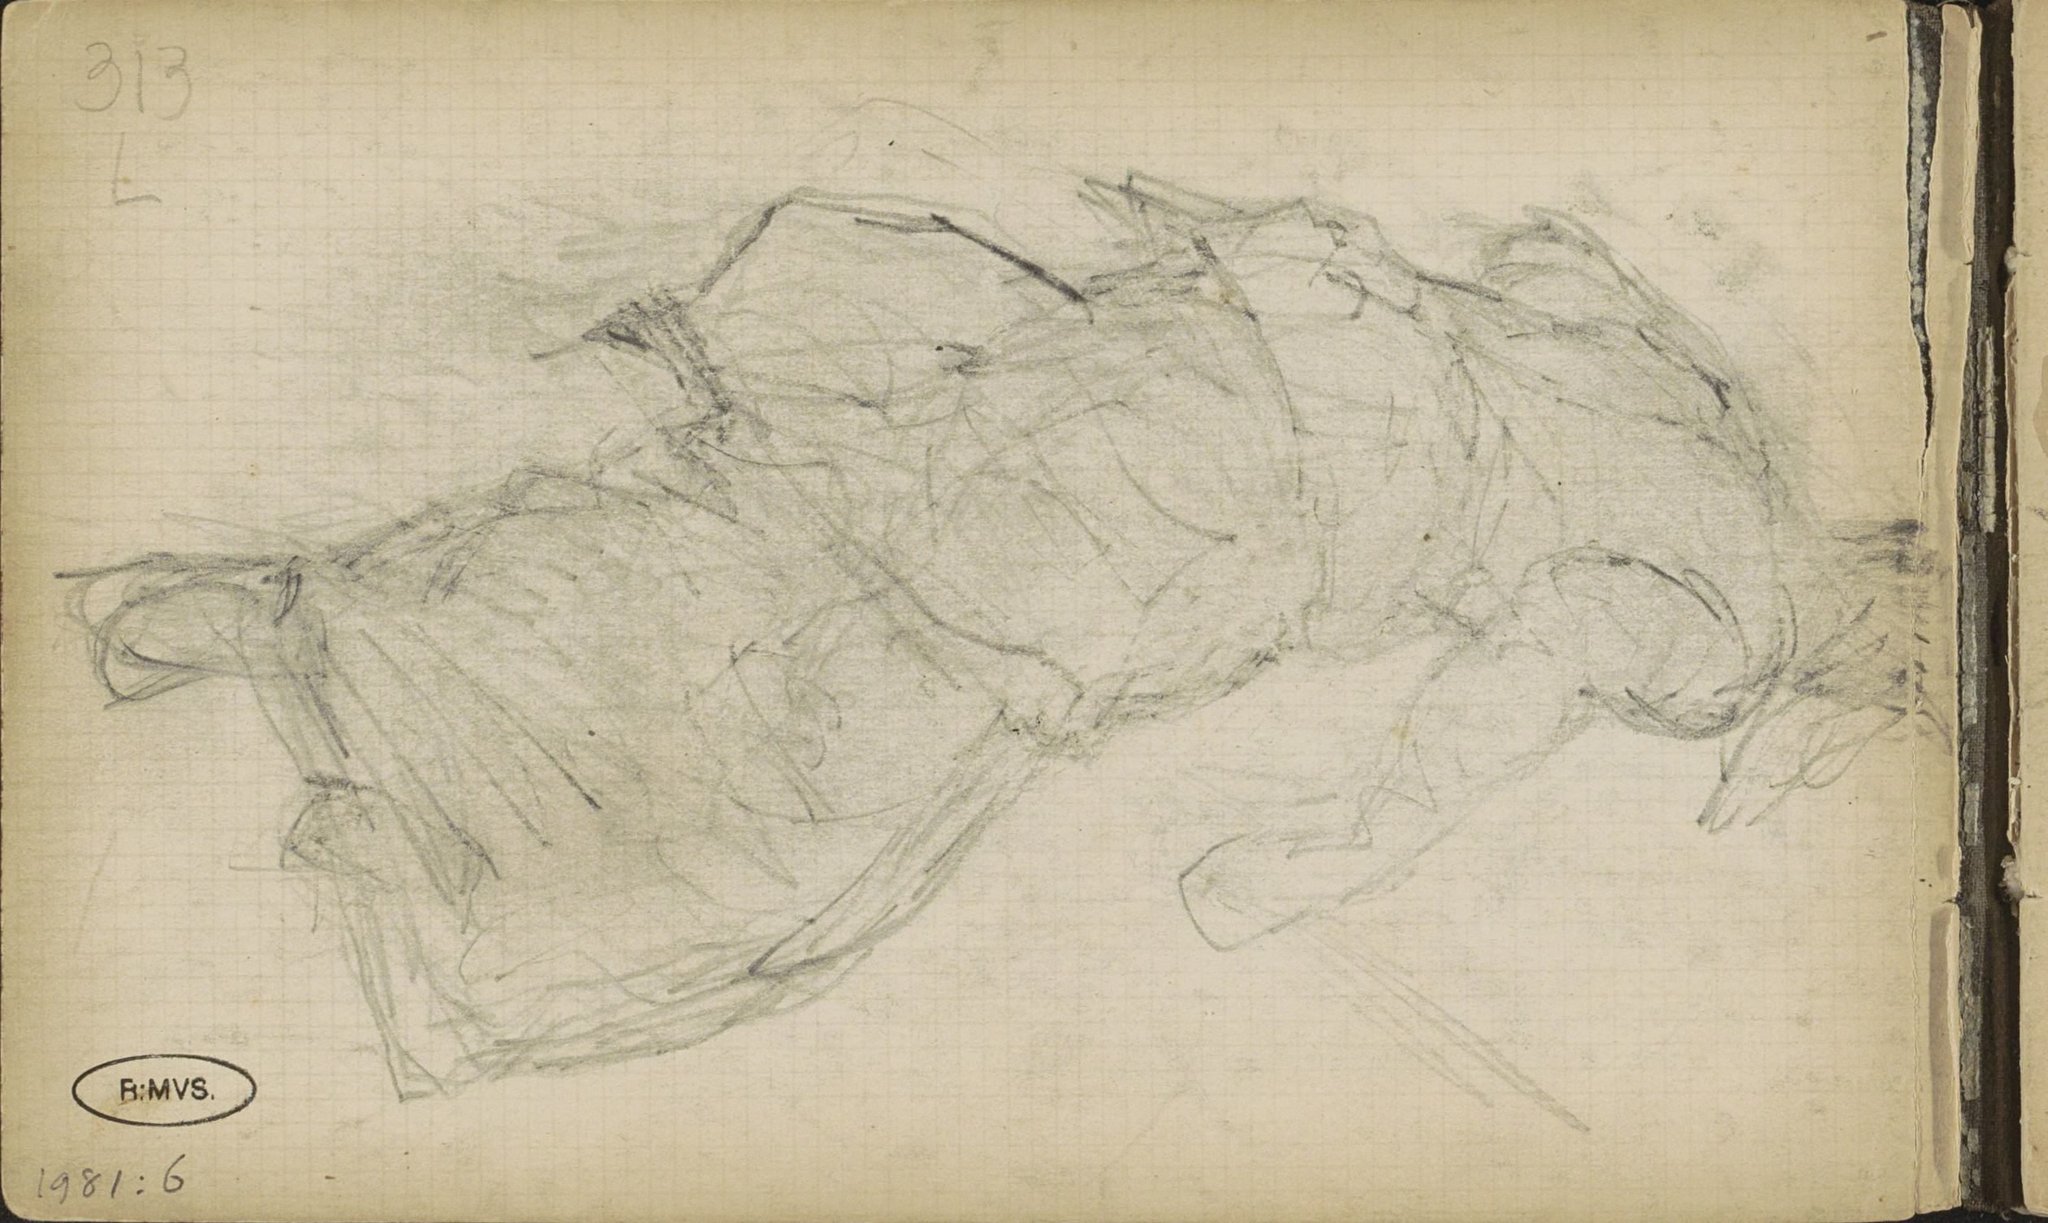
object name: sketchbook leaf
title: Rennende figuur, op de rug gezien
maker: matthijs maris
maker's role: draughtsman, painter, print maker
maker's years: 1839-1917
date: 1849-1917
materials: pencil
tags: running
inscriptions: collector's mark: Lugt L2228a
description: Voorste schutblad uit een schetsboek met 35 bladen.